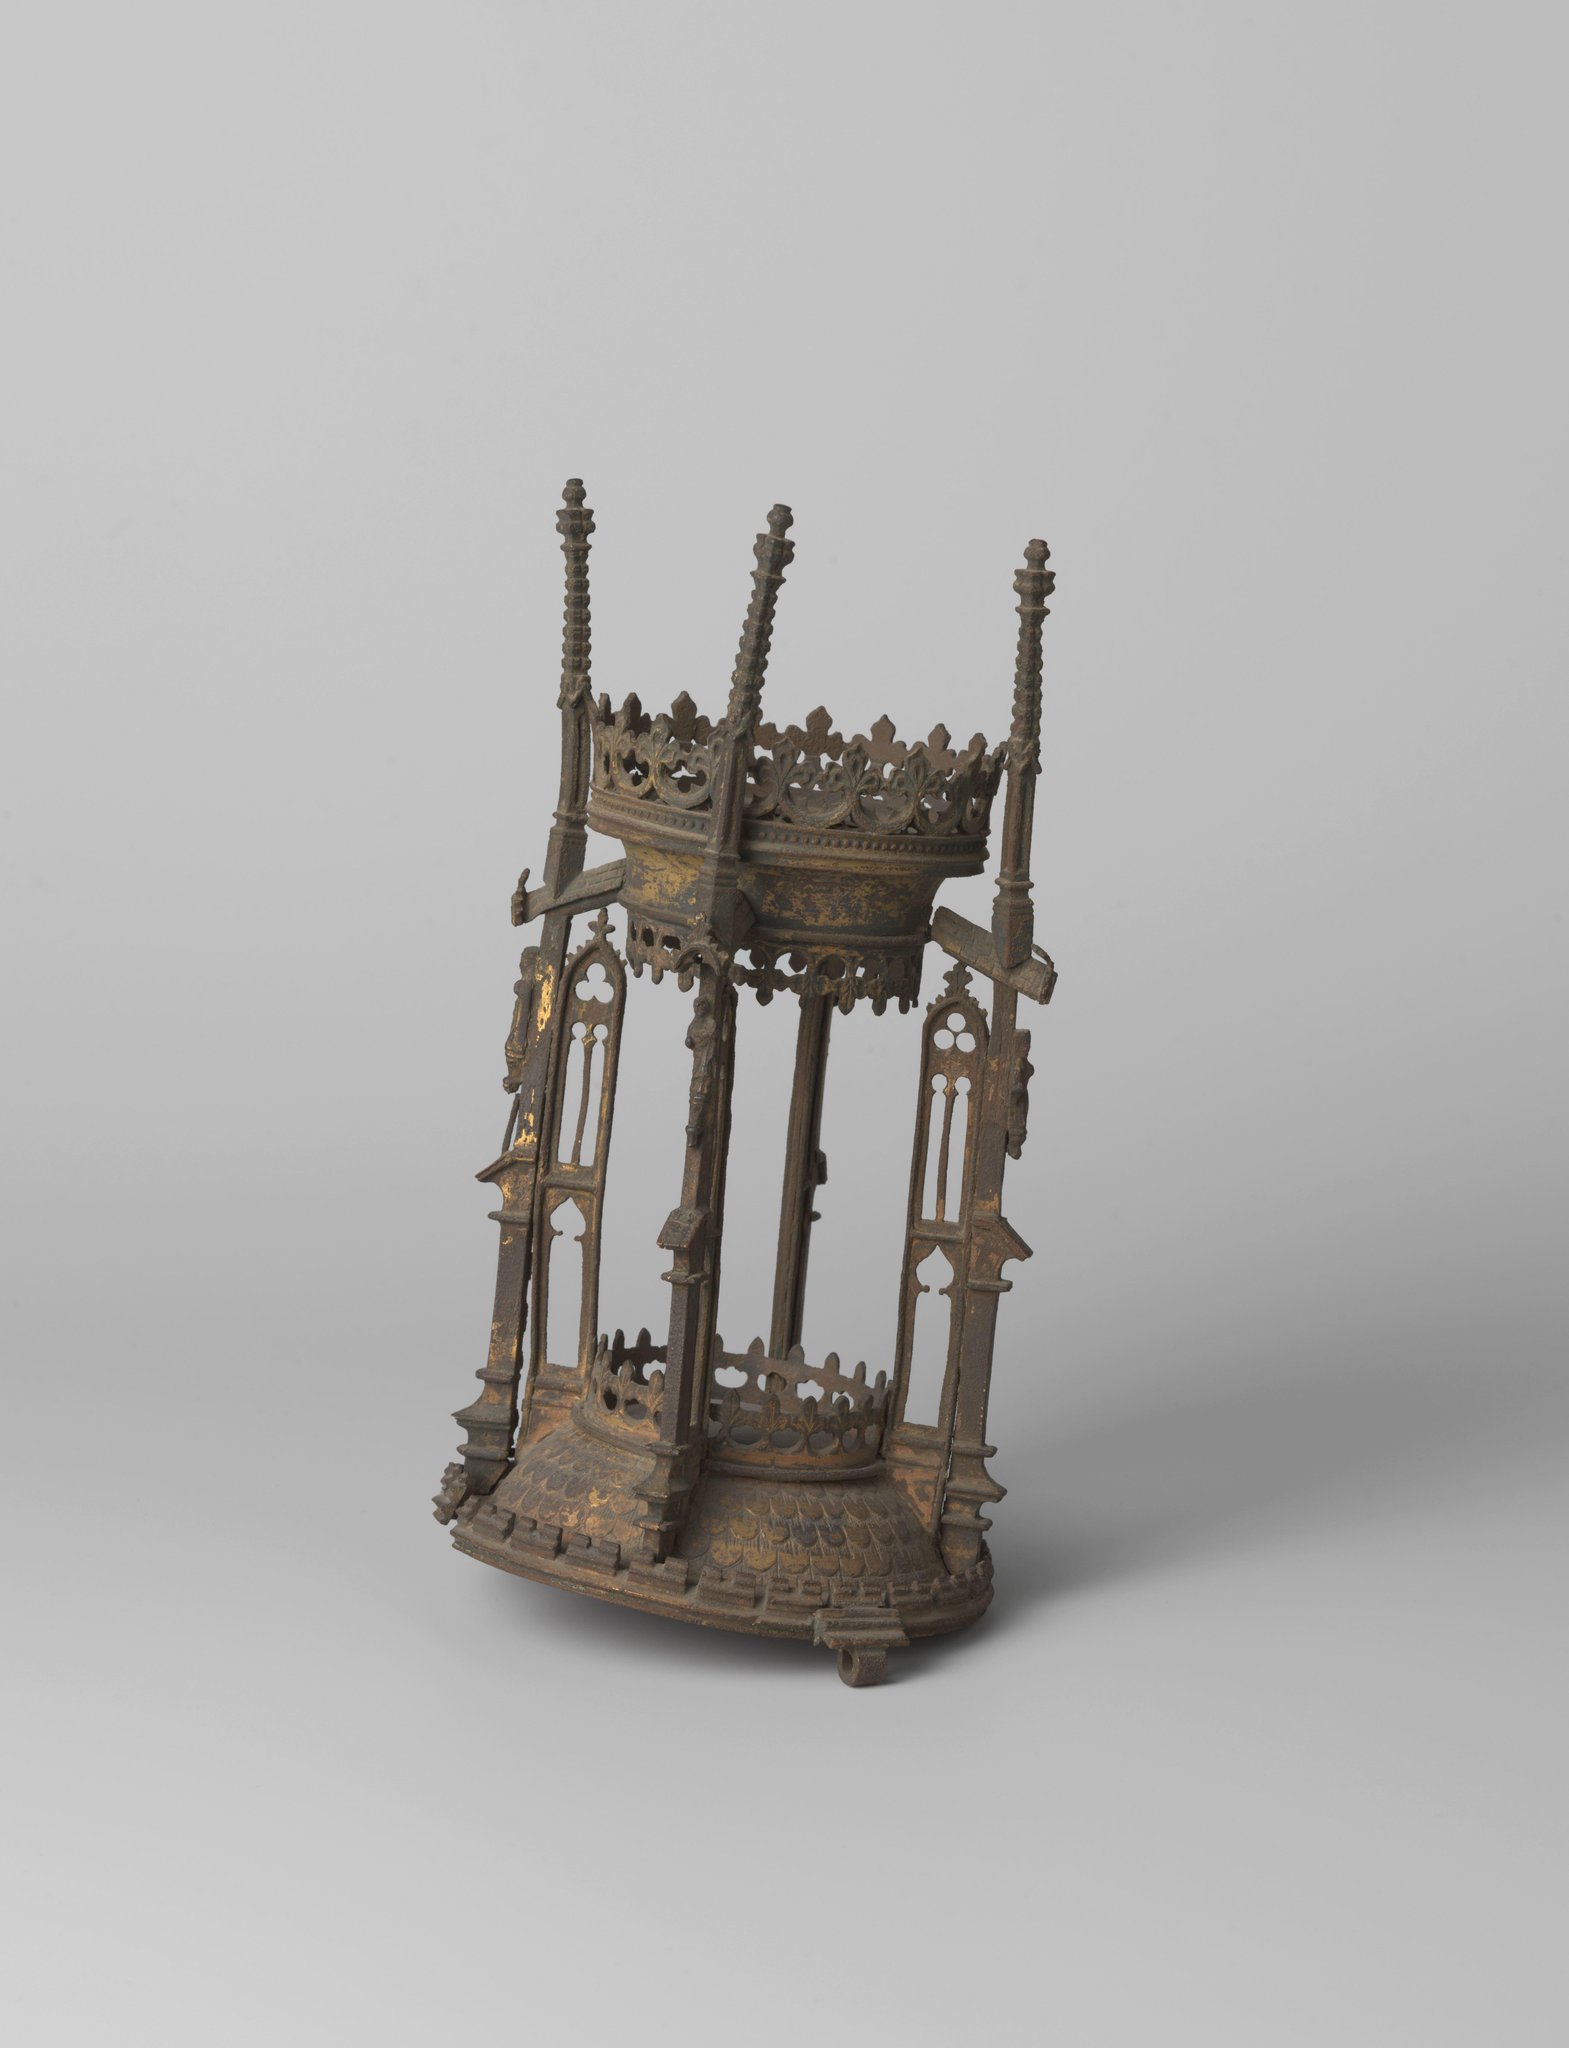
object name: monstrans, ostensorium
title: Fragment van een monstrans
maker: Anonymous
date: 1425-1450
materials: brass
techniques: casting, gilding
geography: cologne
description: Het fragment bestaat uit twee cilindermonturen, gevat tussen vier verticale verbindingsstukken (steunberen), geplaatst op een bolle deksel, welke is gevat in een gekanteelde rand, waartegen aan voor- en achterkant twee ogen zijn bevestigd, waardoor een pin gestoken kan worden. Het fragment onderscheidt zich door deze bevestiging en door de vier in plaats van twee verticale verbindingsstukken van vergelijkbare onderdelen van de overige hier besproken monstransen.